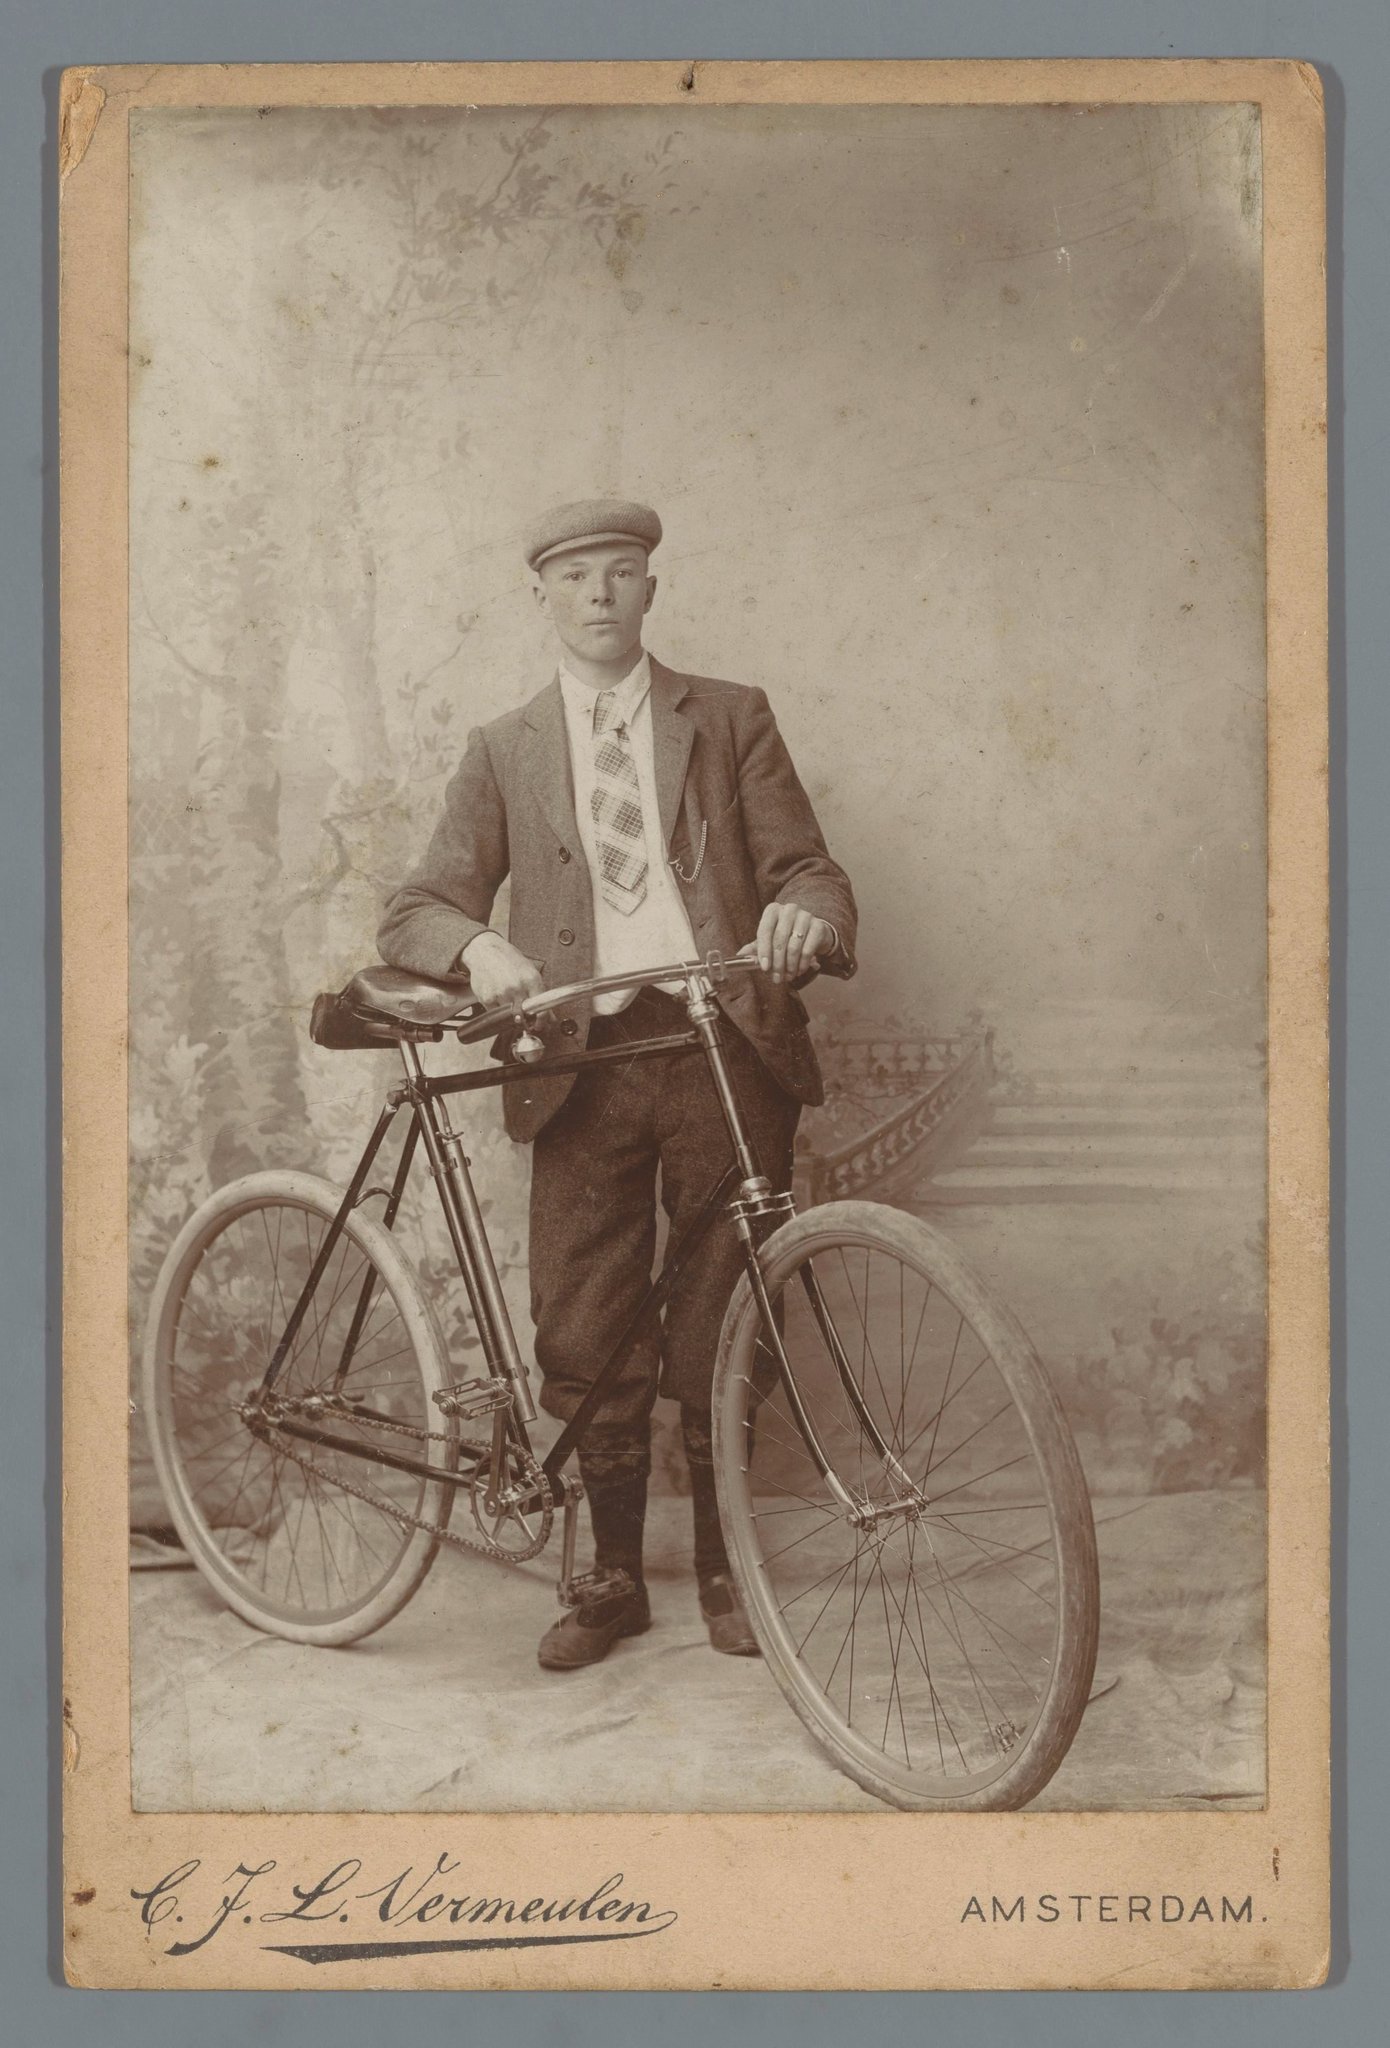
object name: photograph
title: Studioportret van een onbekende man met een fiets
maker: cornelis johannes lodewicus vermeulen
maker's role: fotograaf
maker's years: 1861-1936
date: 1895-1910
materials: cardboard, photographic support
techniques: gelatin silver print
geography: amsterdam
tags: adult man, bicycle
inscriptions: inscription: ‘C. J. L. Vermeulen Photographische Ateliers Amsterdam. Heerenstraat 6 & Heiligenweg hoek Singel Specialiteit in vergrootingen’